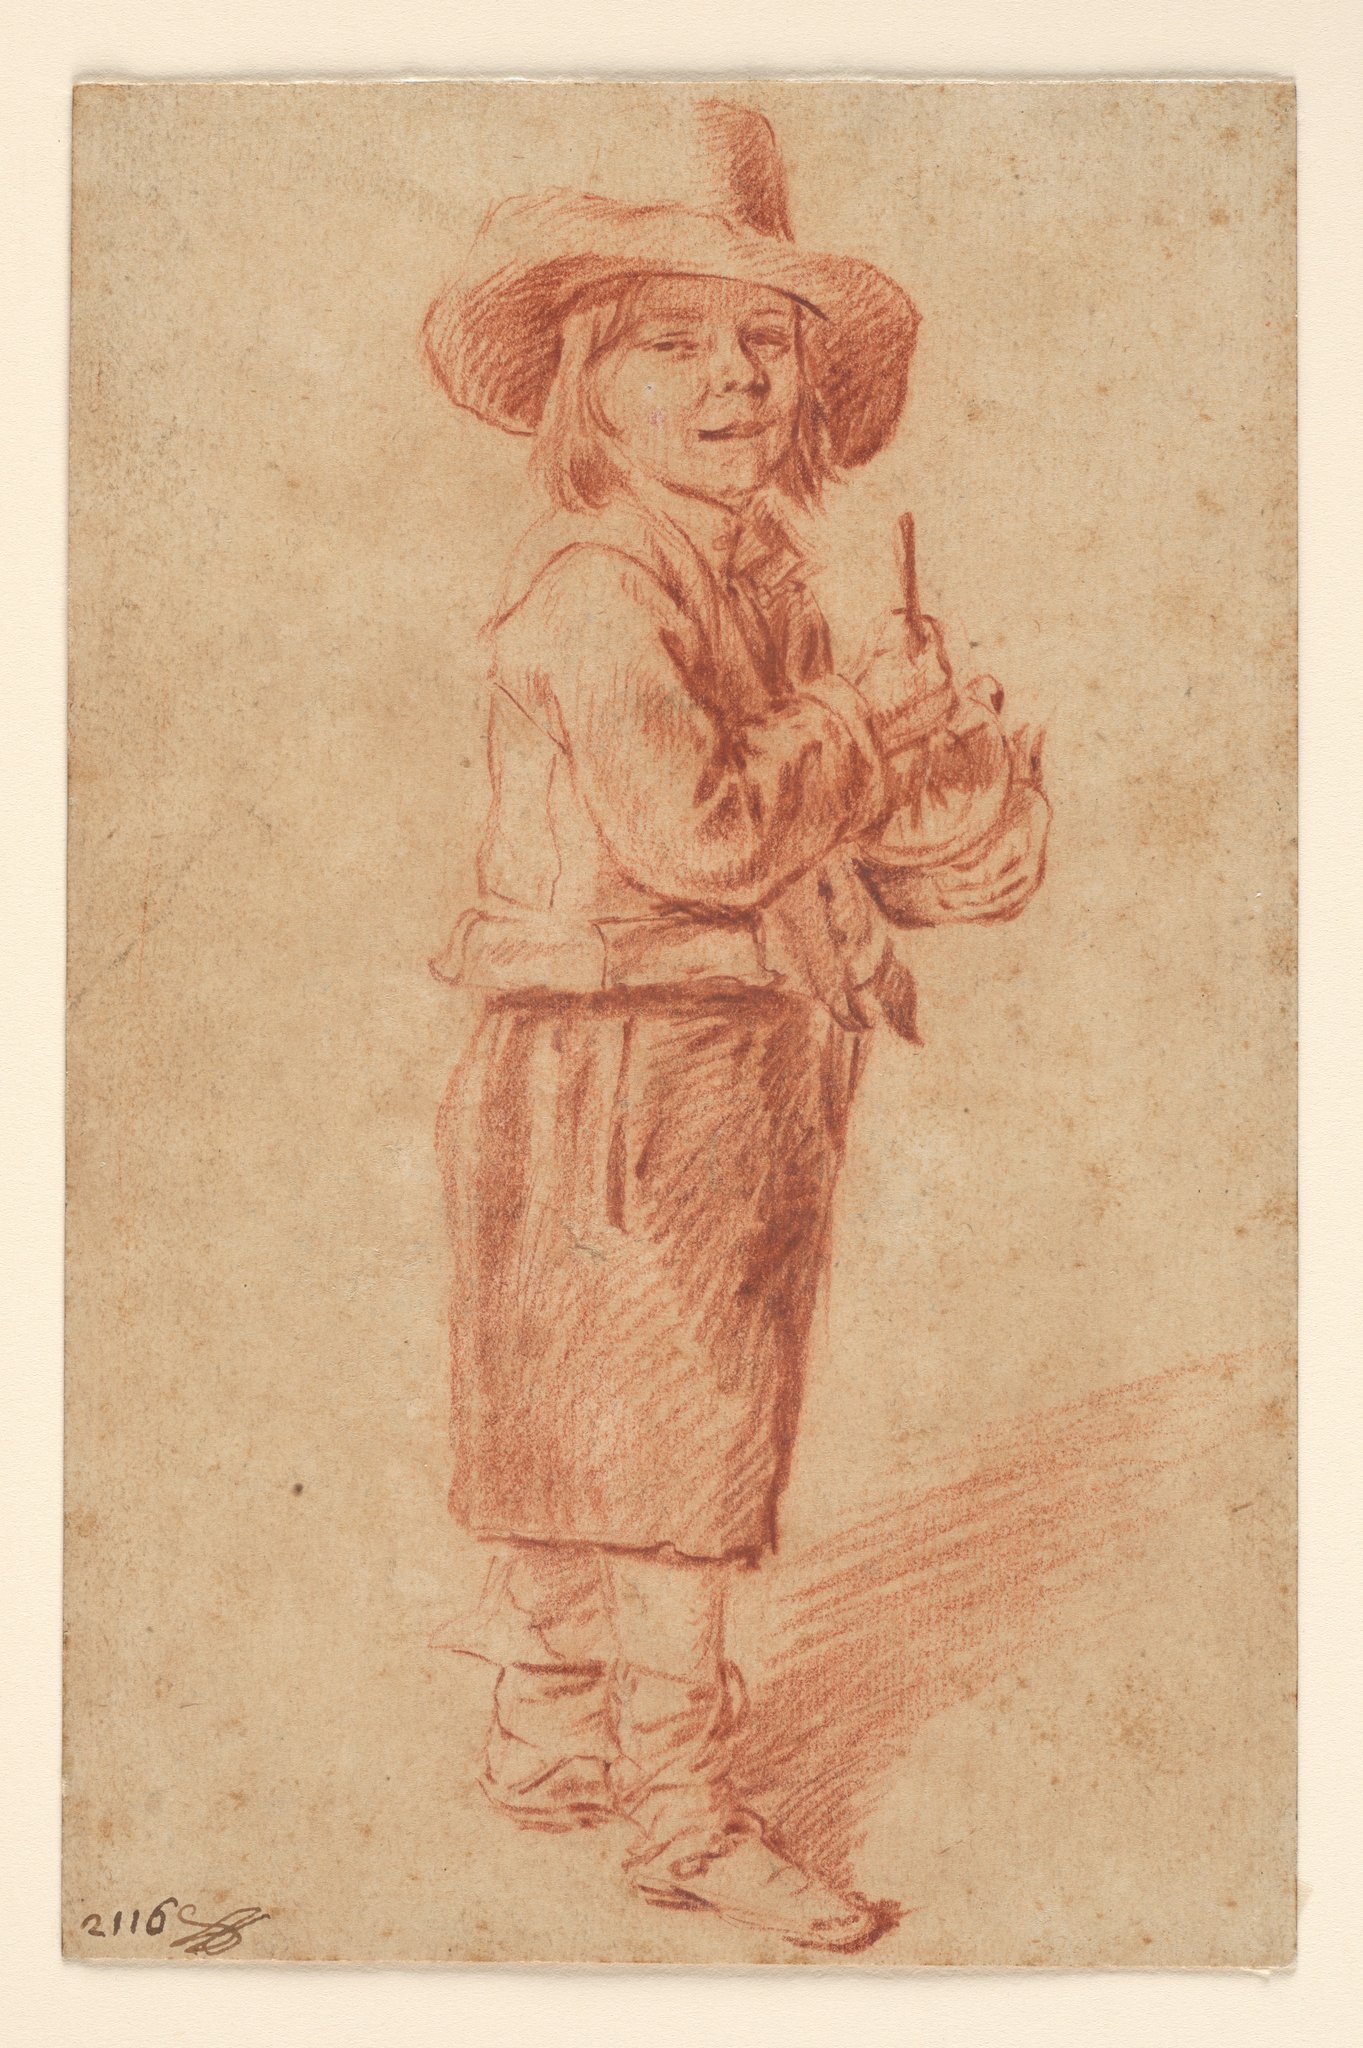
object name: drawing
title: The Rommelpot Player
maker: french (?)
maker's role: artist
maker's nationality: french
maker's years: 1700-1799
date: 1701-1800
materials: chalk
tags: boys